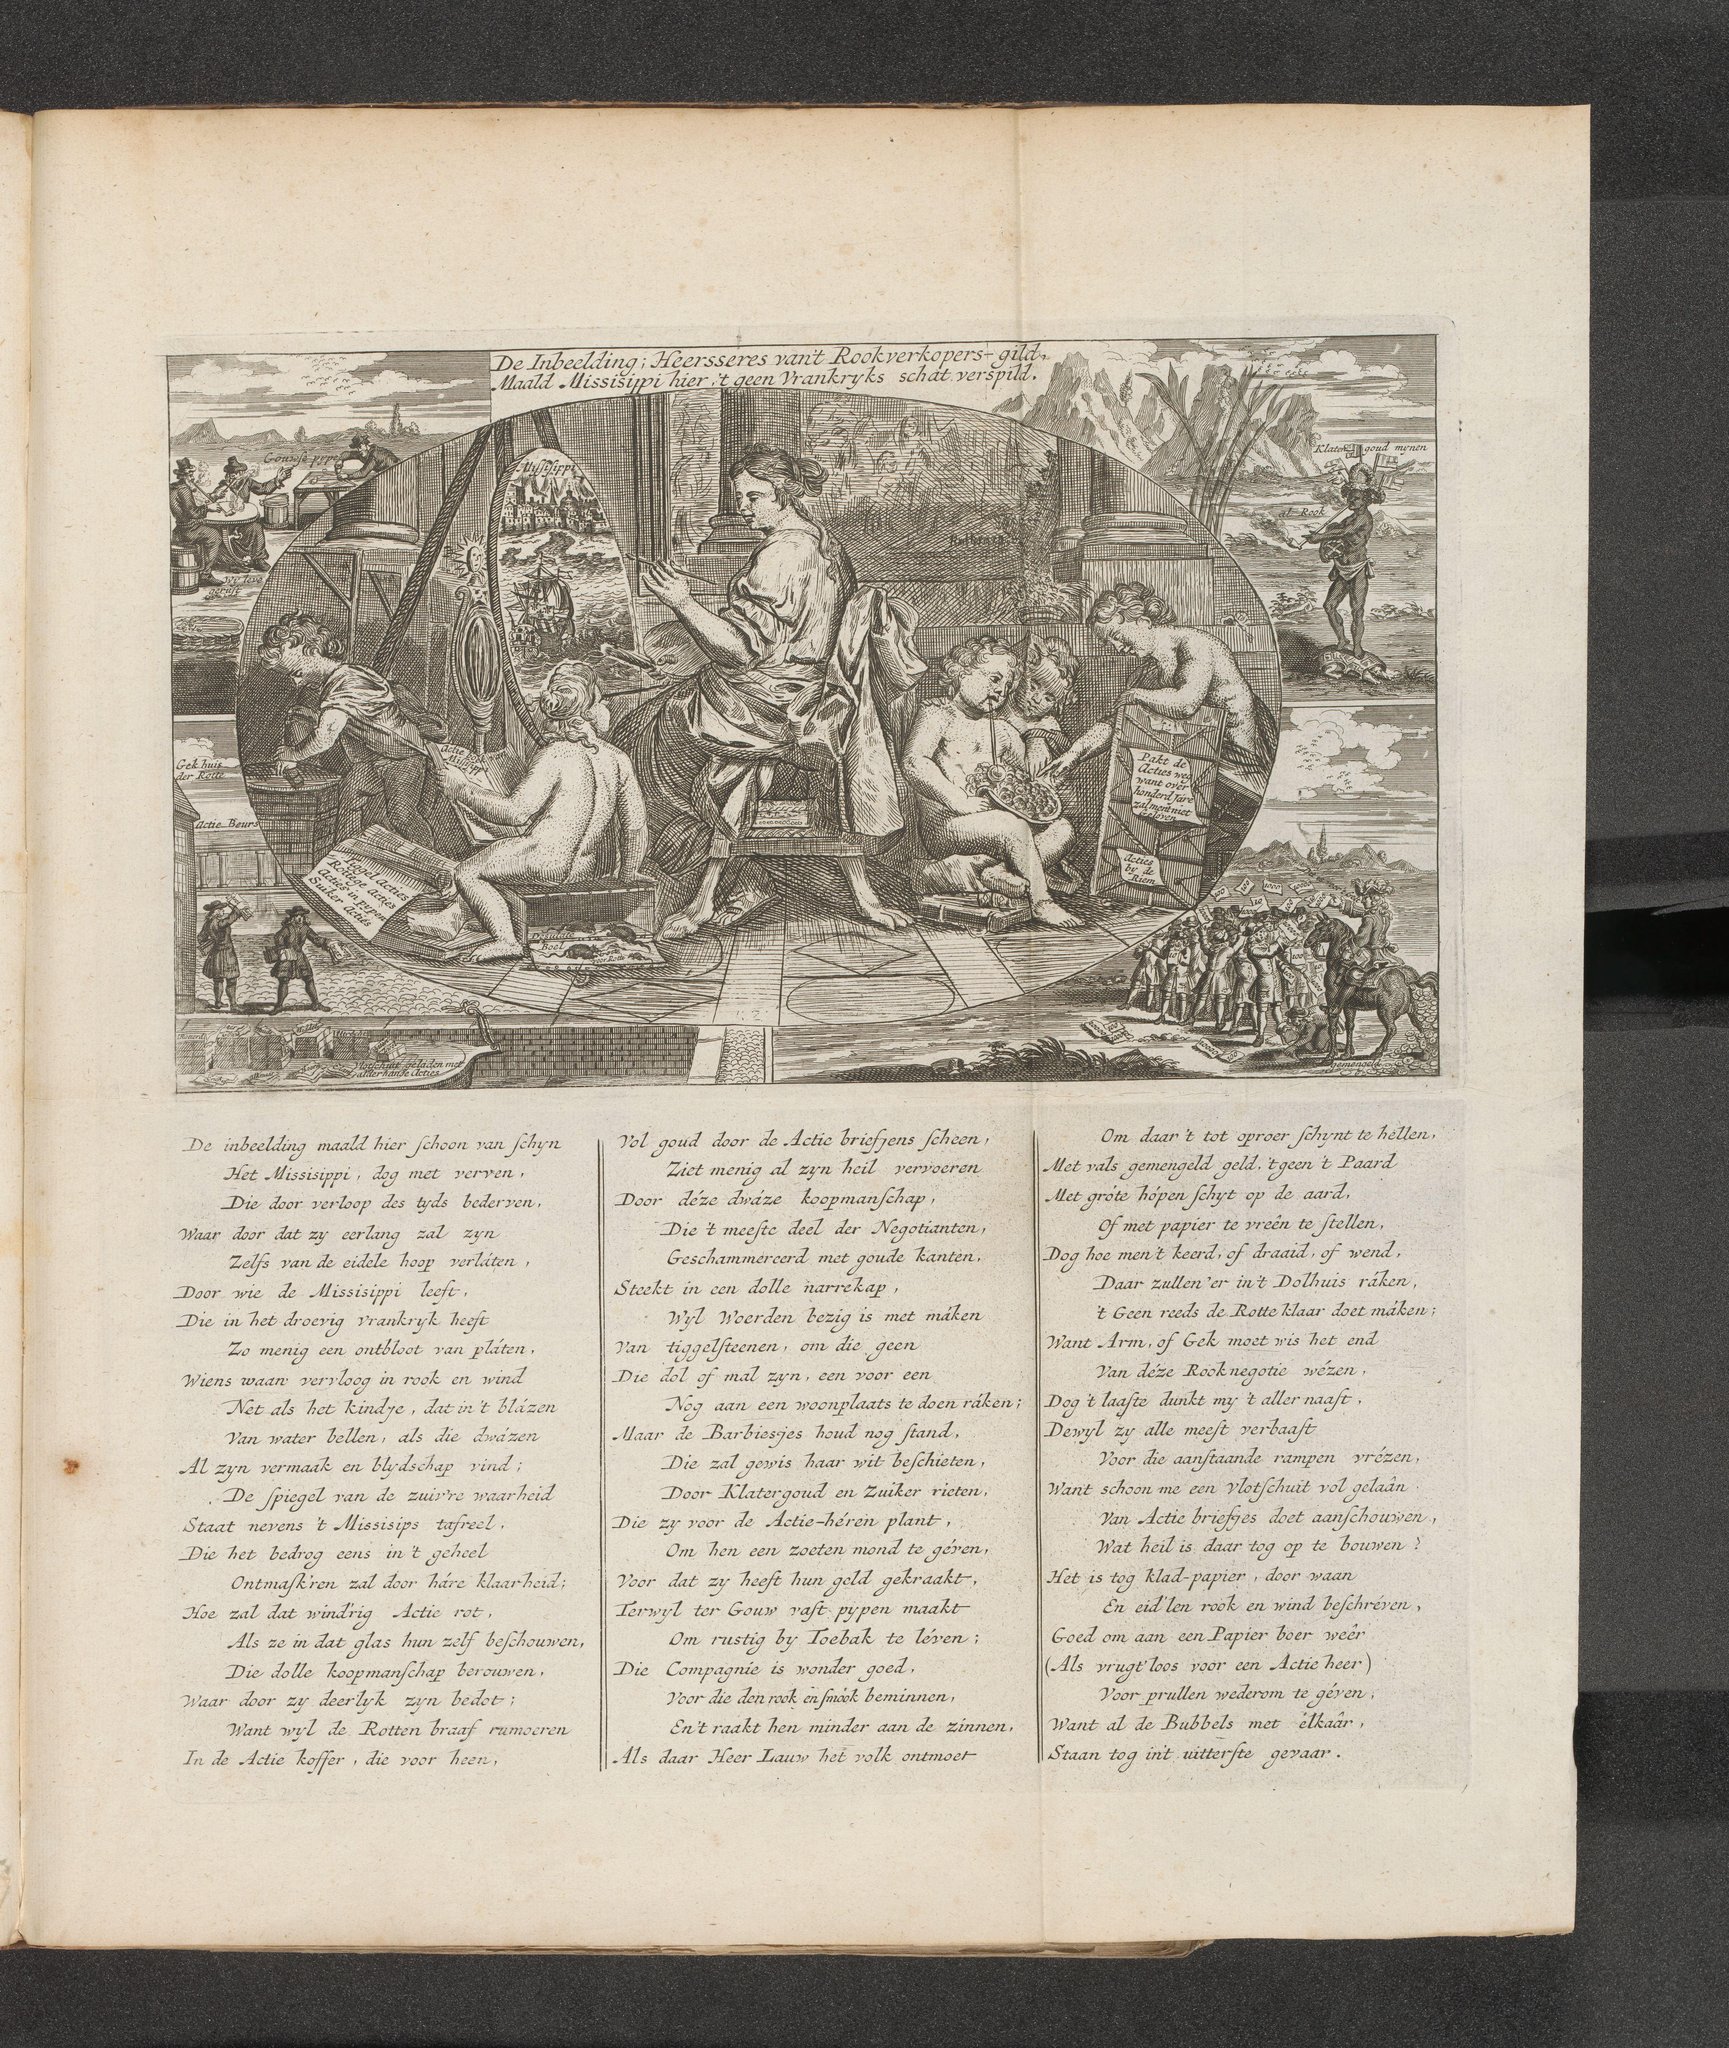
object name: cartoon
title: De Inbeelding; Heersseres van 't Rookverkopers-gild, Maald Missisippi hier, 't geen Vrankryks schat verspild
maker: Anonymous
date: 1720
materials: paper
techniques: etching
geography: northern netherlands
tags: painter at work, in his studio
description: De vrouwelijke personificatie van de Inbeelding schildert een schilderij van de Mississippi, om haar heen kinderen die bellen blazen of lezen uit de actieboek van de Mississippi-Compagnie zittend op een lege geldkist. Met vier kleine scènes van andere mislukte ondernemingen. Onder de voorstelling een onderschrift met een vers in drie kolommen gedrukt van een aparte plaat. Prent in de gebonden vierde uitgave (304 B 12) van Het Groote Tafereel der Dwaasheid met spotprenten op de Windhandel of Actiehandel van 1720.